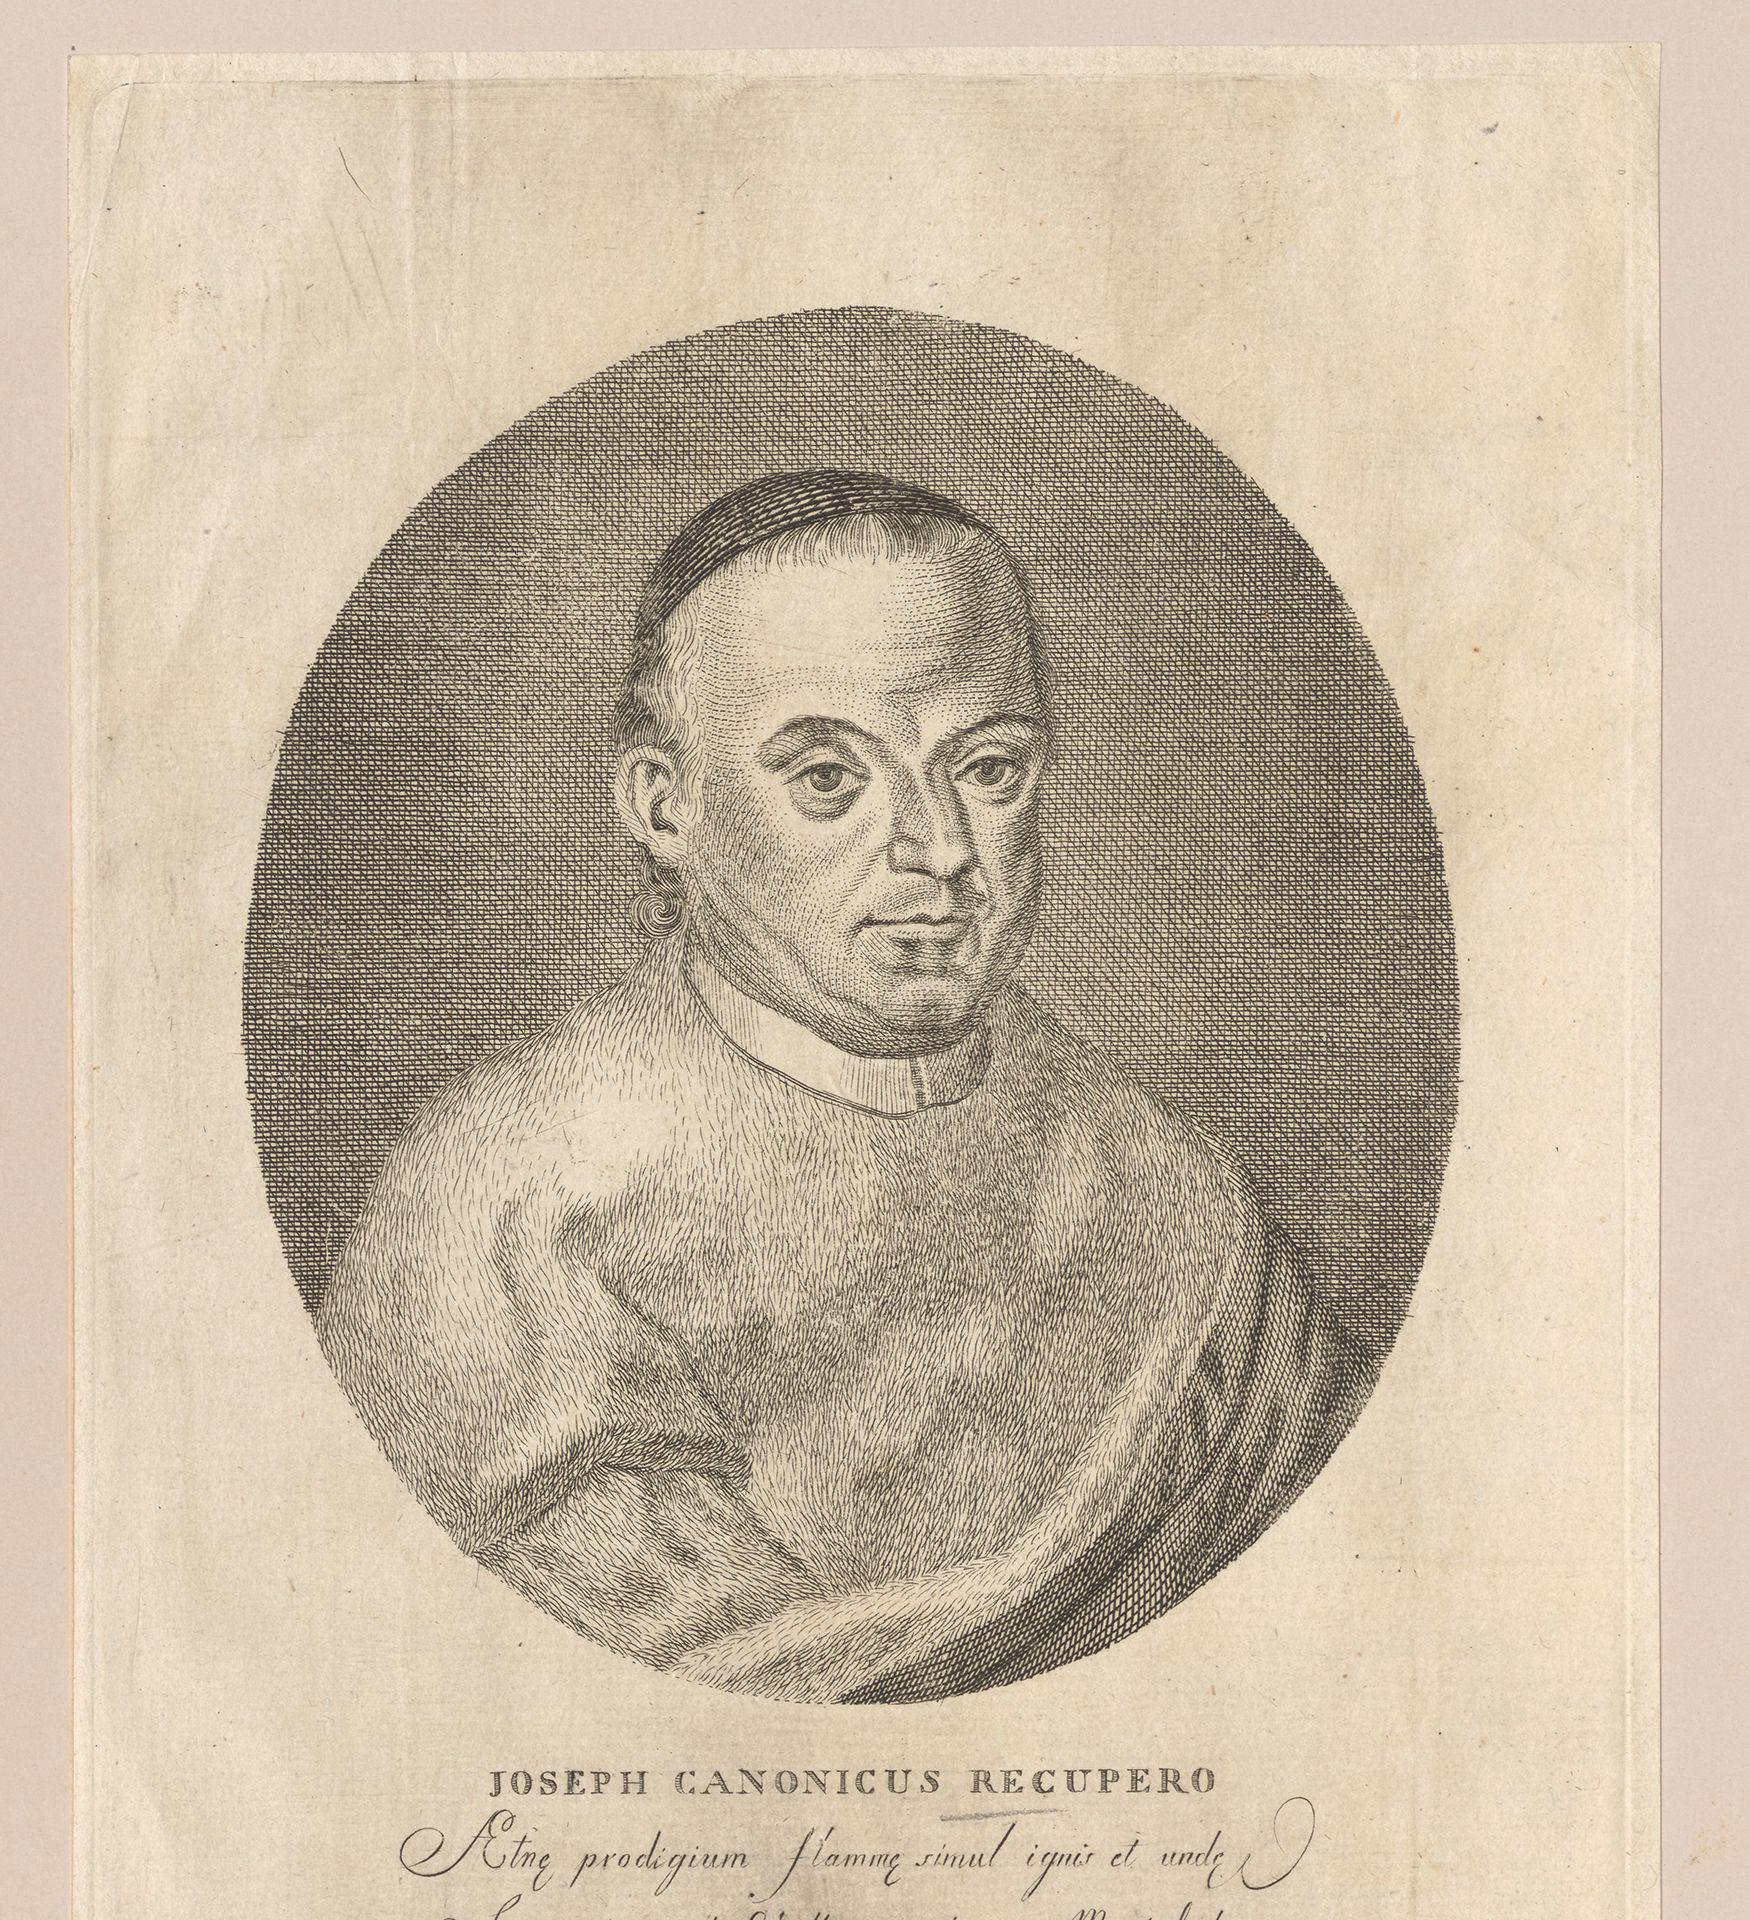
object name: print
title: Portret van Giuseppe Recupero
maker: Anonymous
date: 1815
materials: paper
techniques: engraving, etching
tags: historical persons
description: Prent mogelijk uit: Recupero, Giuseppe. Storia naturale e generale dell'Etna del canonico Giuseppe Recupero (...). Catania: s.n., 1815, dl. 1.